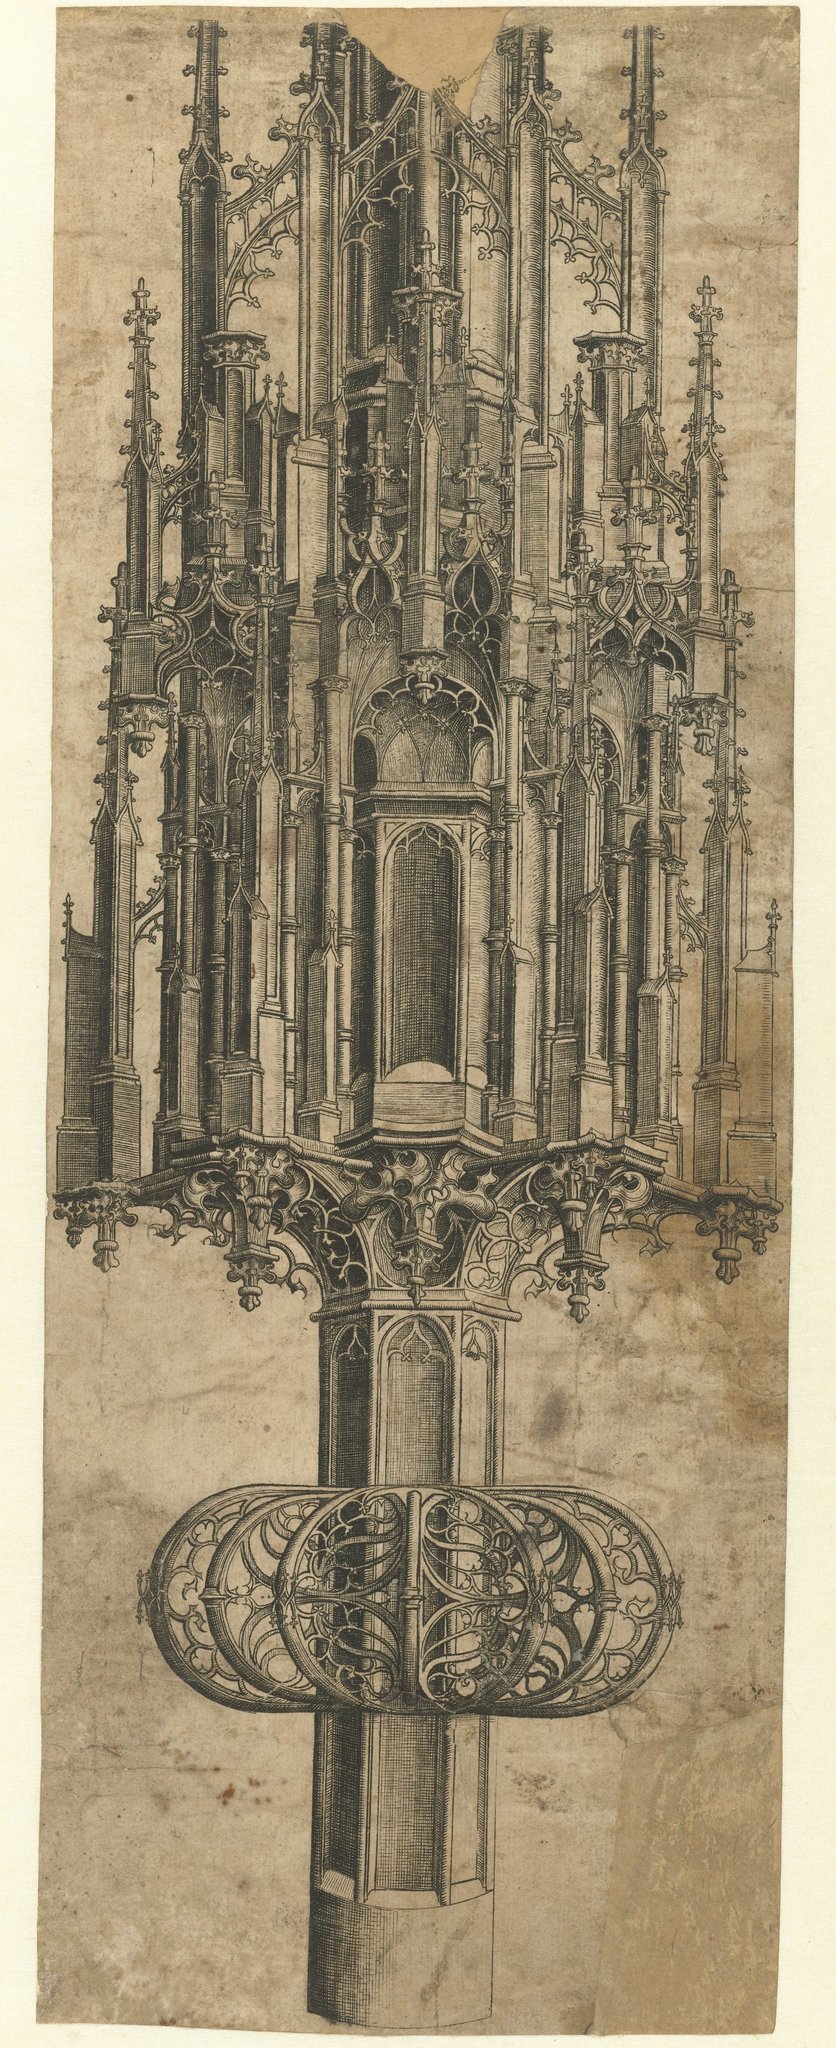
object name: print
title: Bisschopstaf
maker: monogrammist wa met de sleutel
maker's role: print maker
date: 1465-1485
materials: paper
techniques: engraving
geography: low countries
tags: insignia of bishop, e.g. mitre, crozier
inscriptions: collector's mark: Lugt 240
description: De onderste helft van een prent met een grote bisschopstaf.